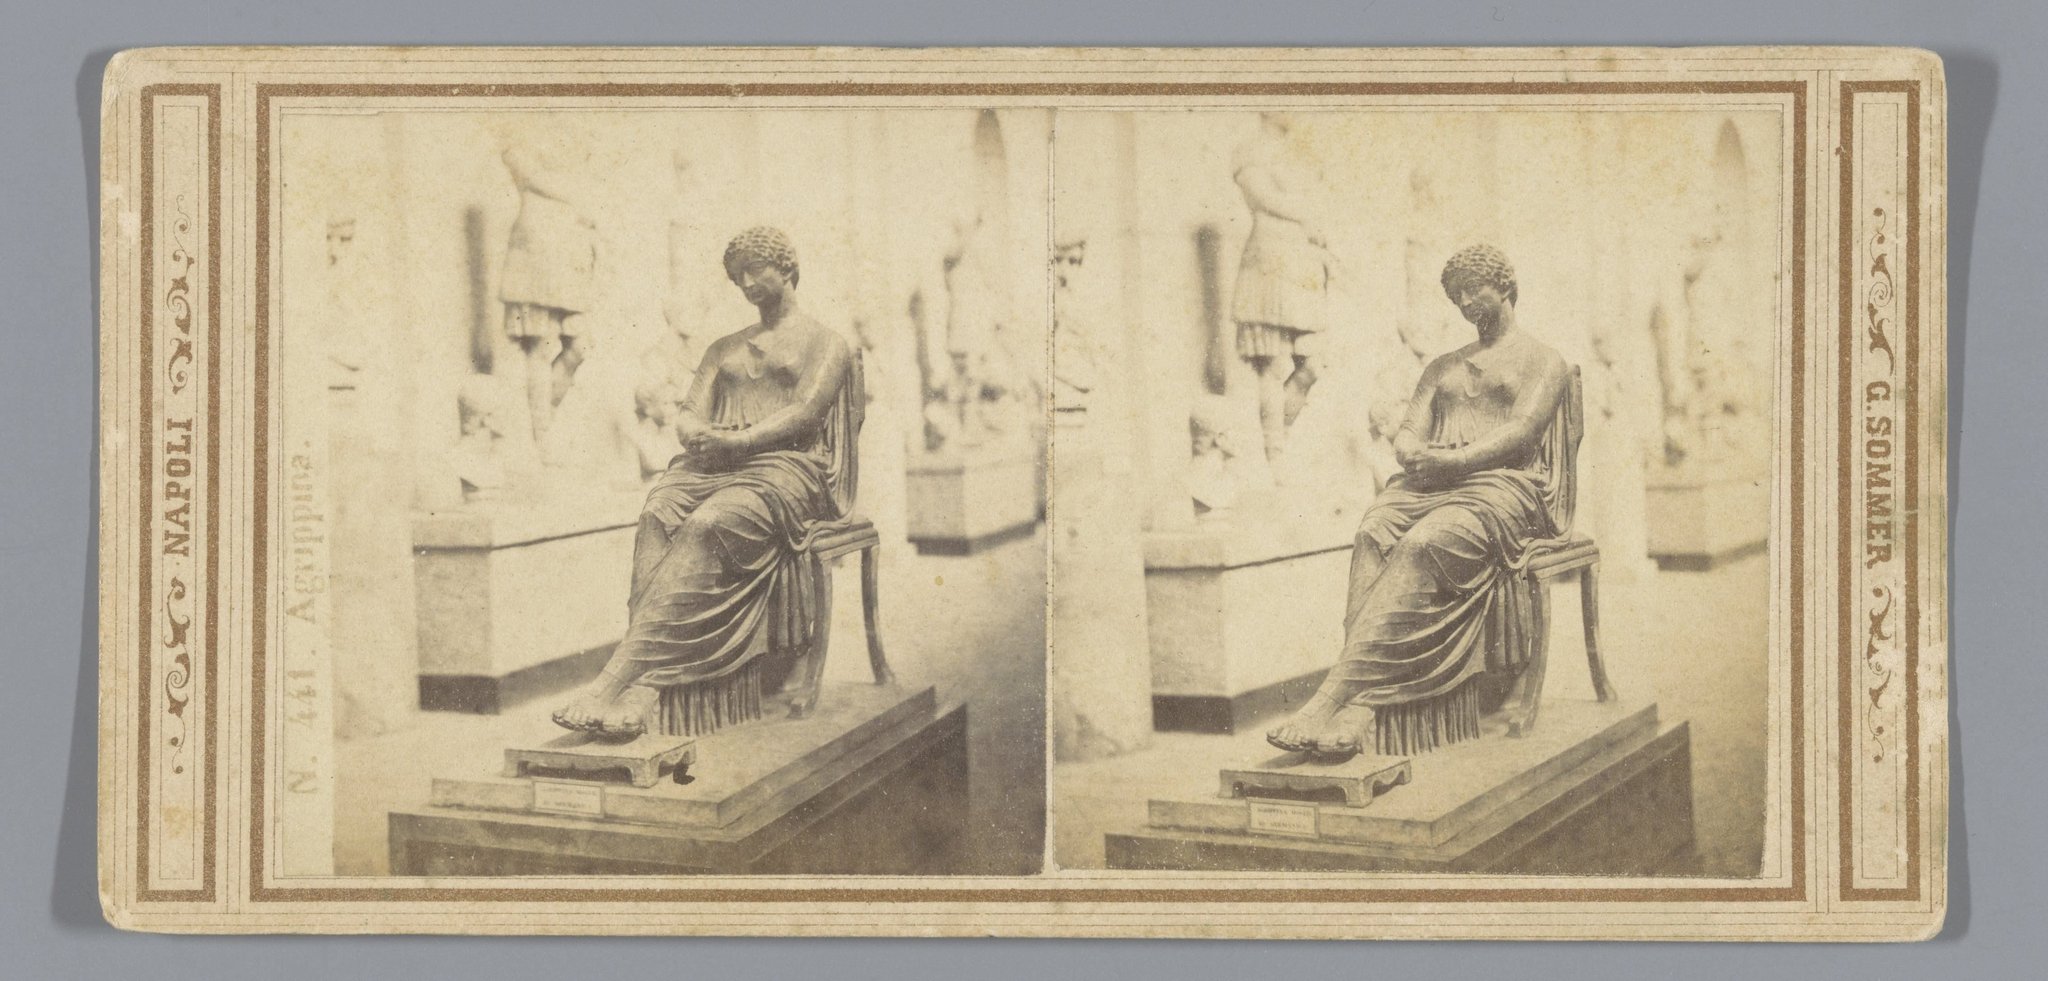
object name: stereograph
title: Napoli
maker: giorgio sommer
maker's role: fotograaf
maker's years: 1834-1914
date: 1860-1880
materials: cardboard, photographic support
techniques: albumen print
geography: naples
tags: piece of sculpture, reproduction of a piece of sculpture, naples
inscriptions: number: ‘No. 441.’